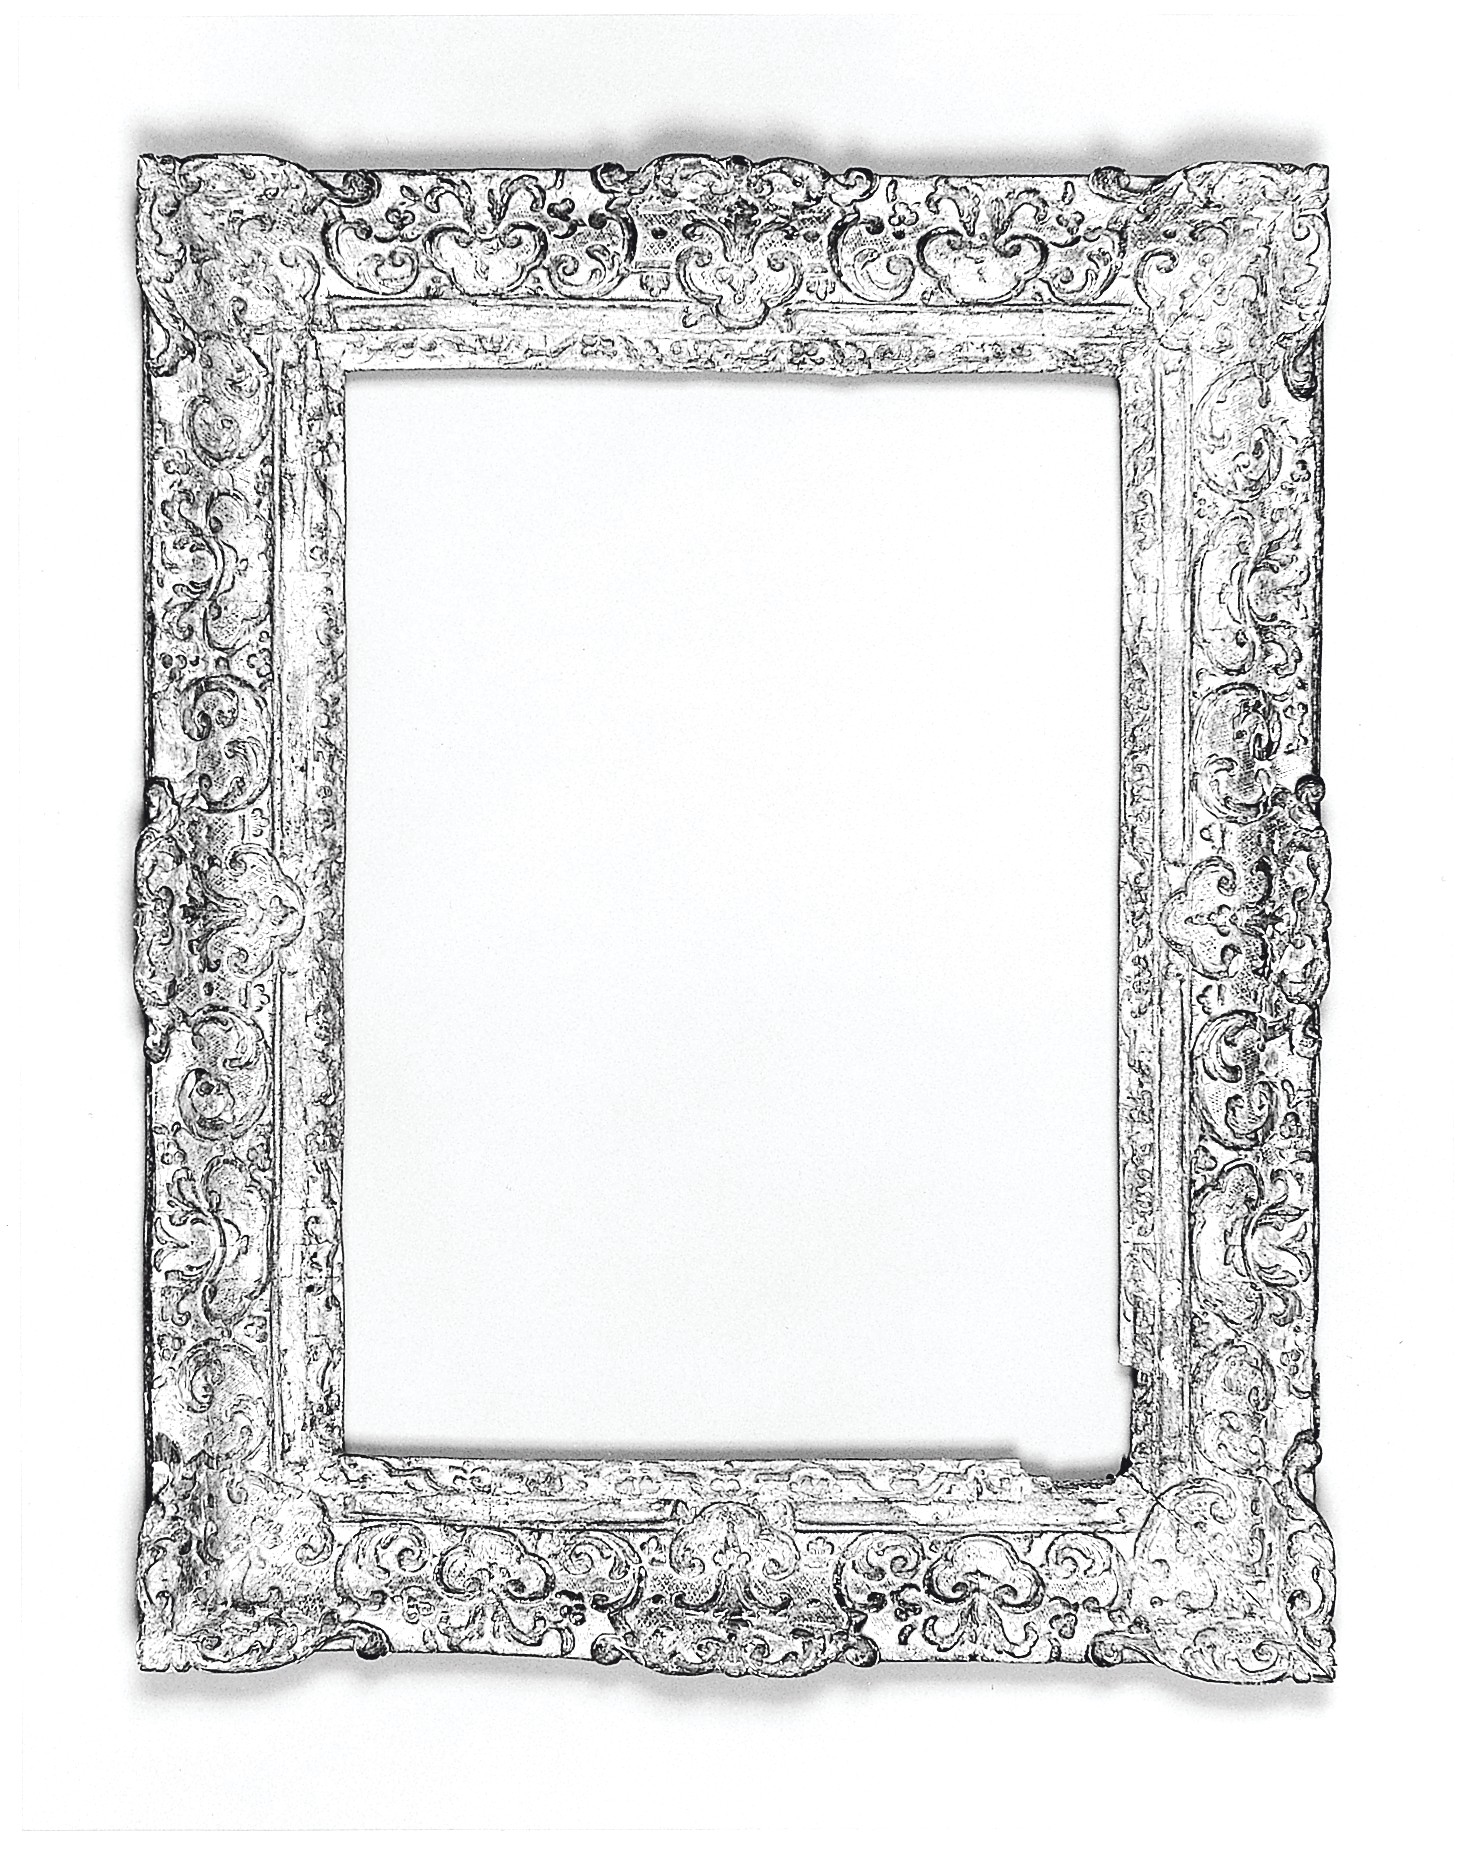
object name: frame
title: Ogee frame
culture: french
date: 1710-1730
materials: wood